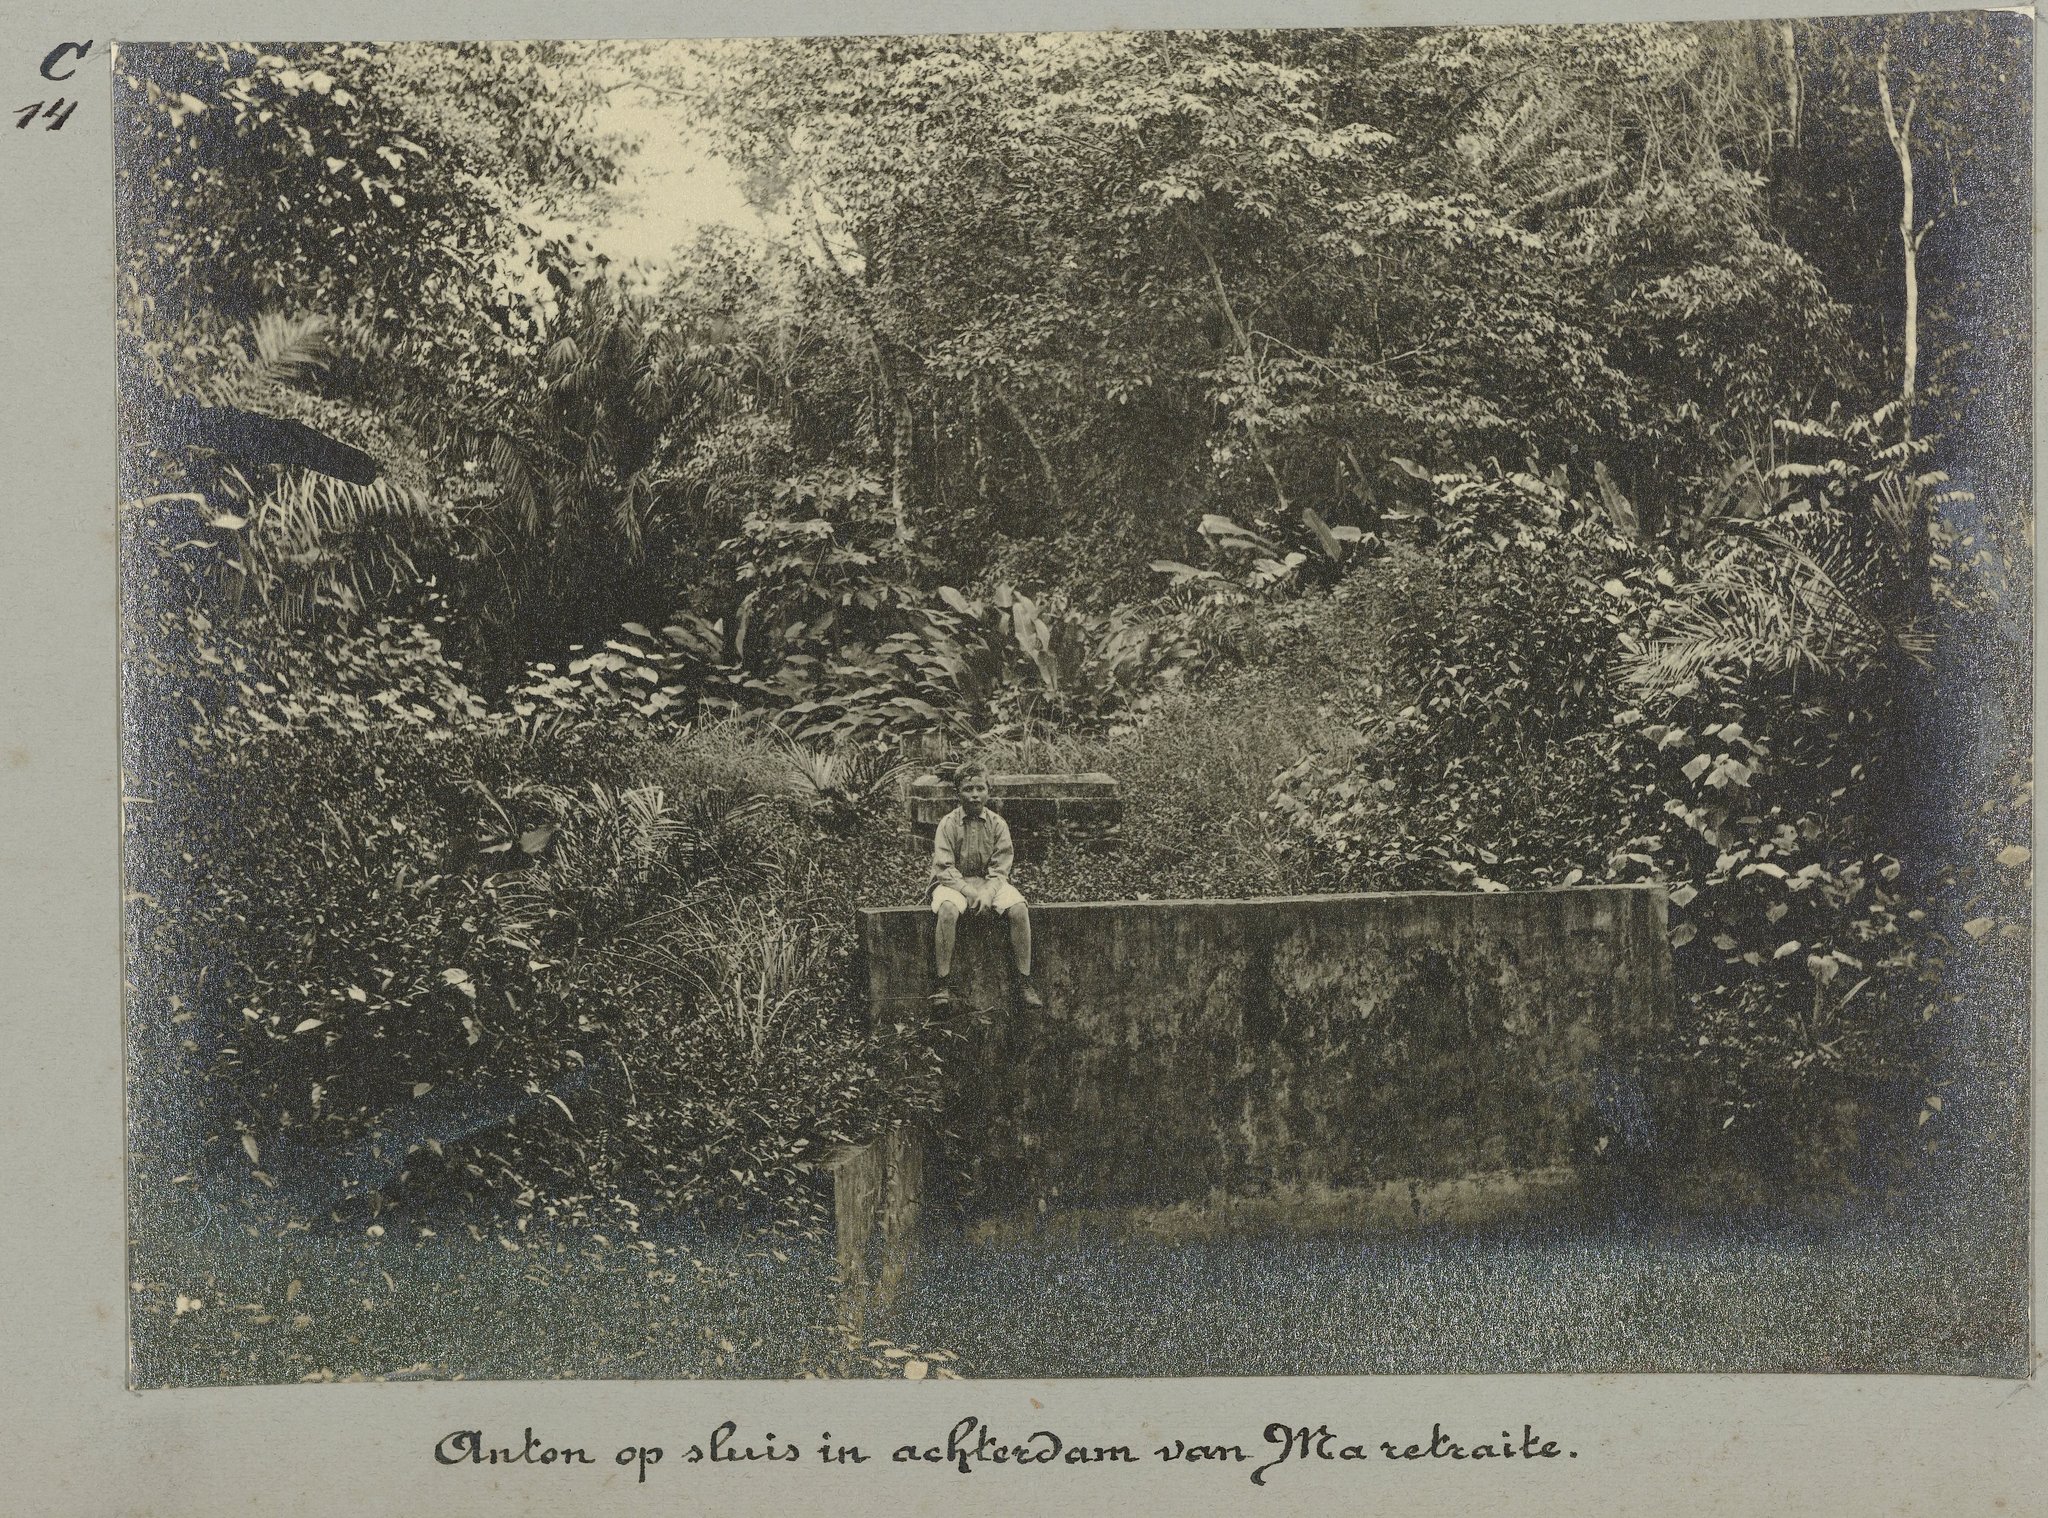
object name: photograph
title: Anton op sluis in achterdam van Ma retraite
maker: hendrik doijer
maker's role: engineer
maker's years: 1863-1925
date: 1903-1910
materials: photographic support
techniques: gelatin silver print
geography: suriname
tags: suriname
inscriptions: inscription: ‘C14 / Anton op sluis in achterdam van Ma retraite.’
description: De Nederlandse jongen genaamd Anton zittend op de wand van de sluis in de achterdam op het terrein van de plantage Ma Retraite. Onderdeel van het fotoalbum Souvenir de Voyage (deel 2), over het leven van de familie Doijer in en rond de plantage Ma Retraite in Suriname in de jaren 1903-1910.